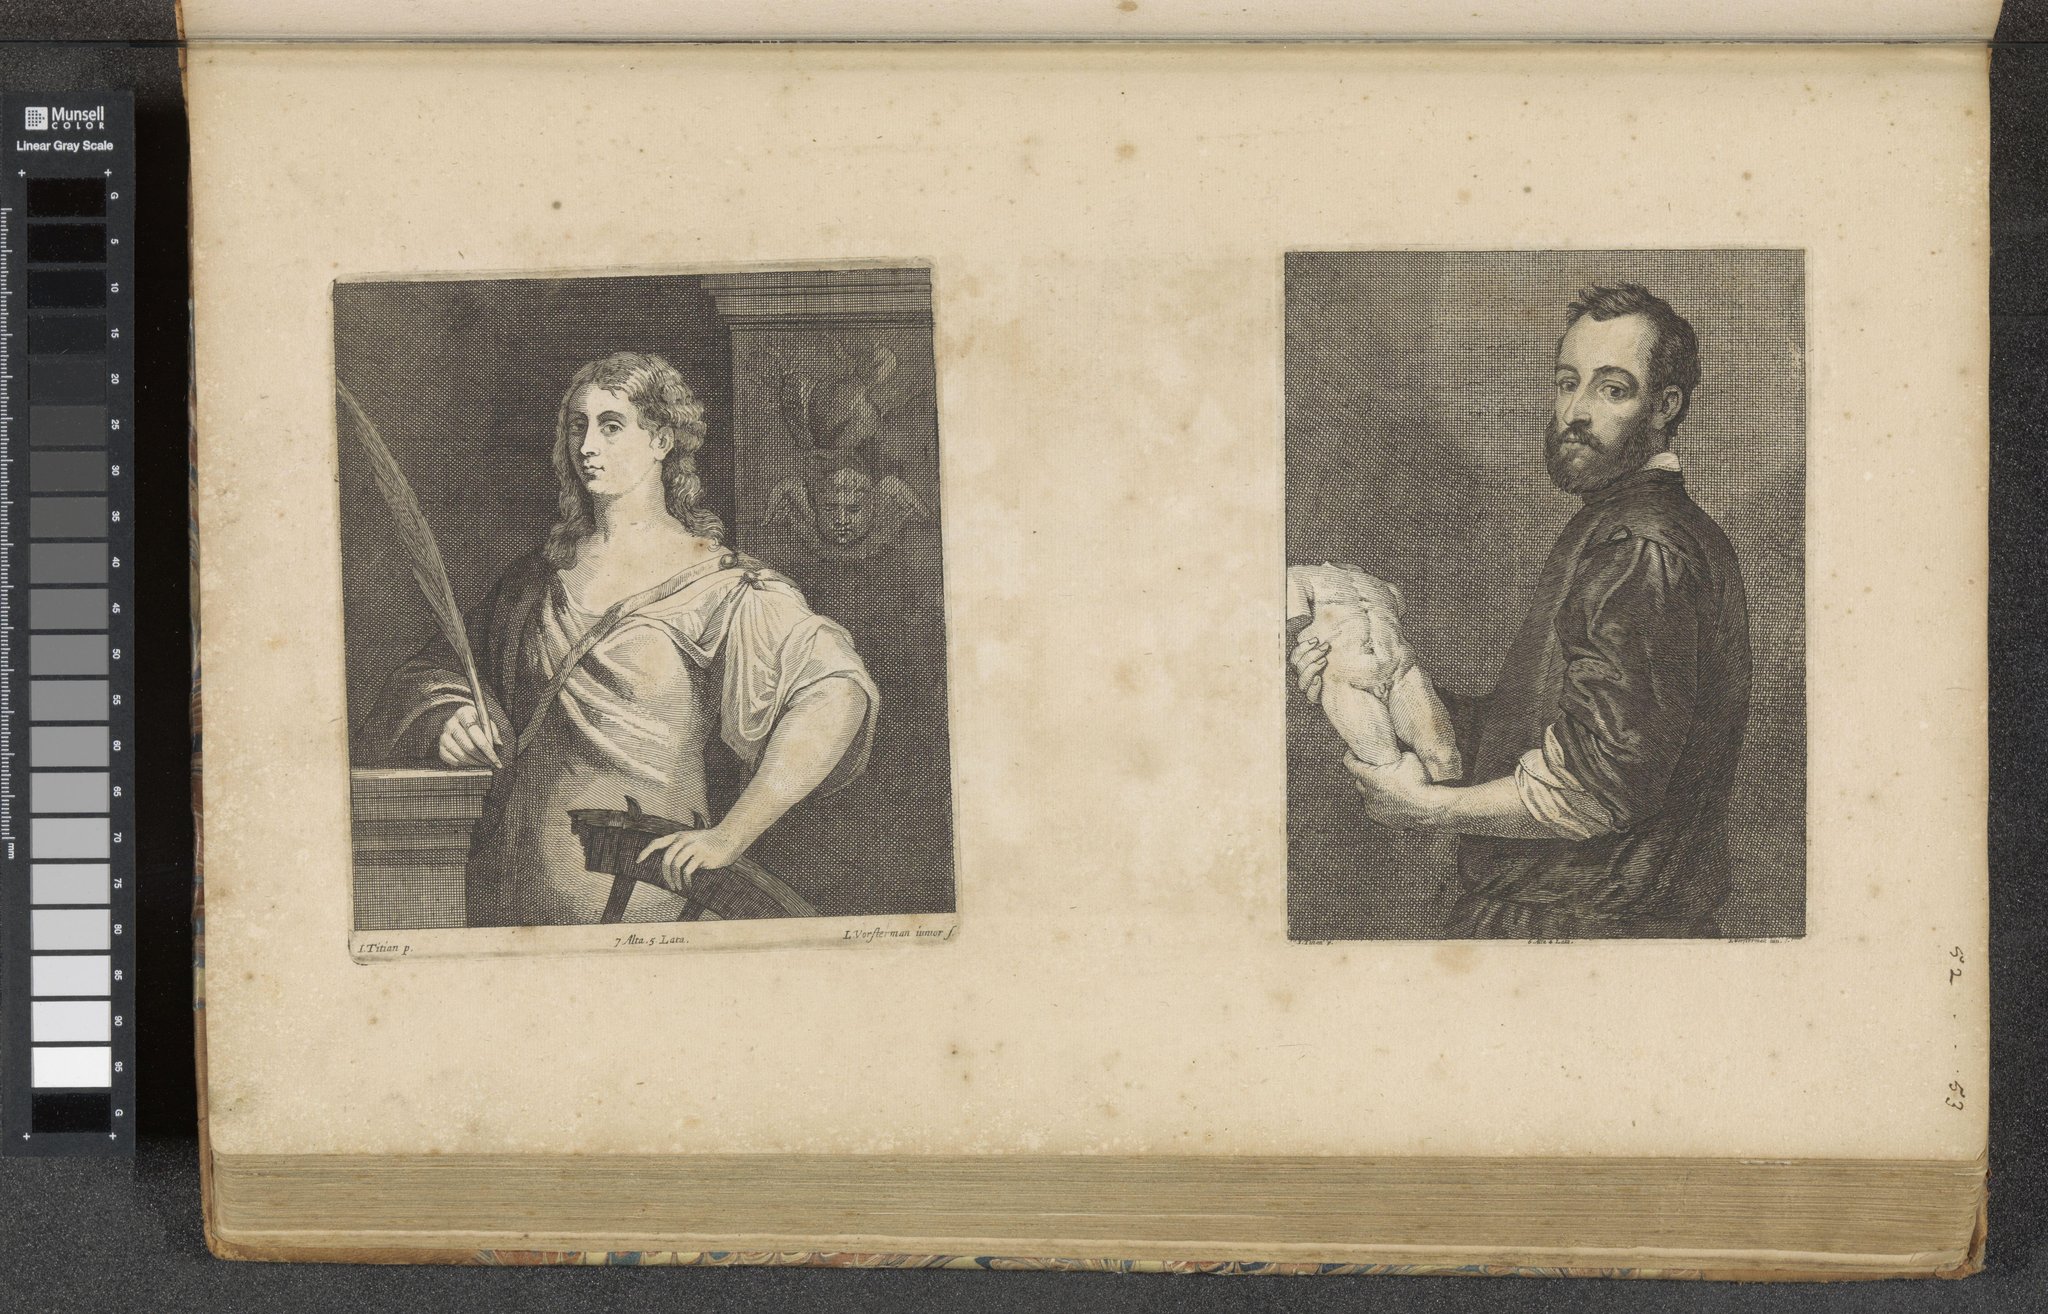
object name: album leaf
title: H. Catharina van Alexandrië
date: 1660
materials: paper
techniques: etching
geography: antwerp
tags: the virgin martyr catherine of alexandria; possible attributes: book, crown, emperor maxentius, palm-branch, ring, sword, wheel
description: De prent is vervaardigd naar een Venetiaans schilderij dat zich in de collectie van het Kunsthistorisches Museum te Wenen bevindt (inventarisnummer GG_59). David Teniers heeft waarschijnlijk van alle schilderijen uit de collectie van Leopold Willem van Oostenrijk een olieverfstudie op doek of paneel vervaardigd (zgn. pasticcio), die als voorbeeld voor de prentmakers diende. Het is niet altijd duidelijk of de pasticci door hem zijn gemaakt of door zijn atelier. Niet alle pasticci zijn overgeleverd.